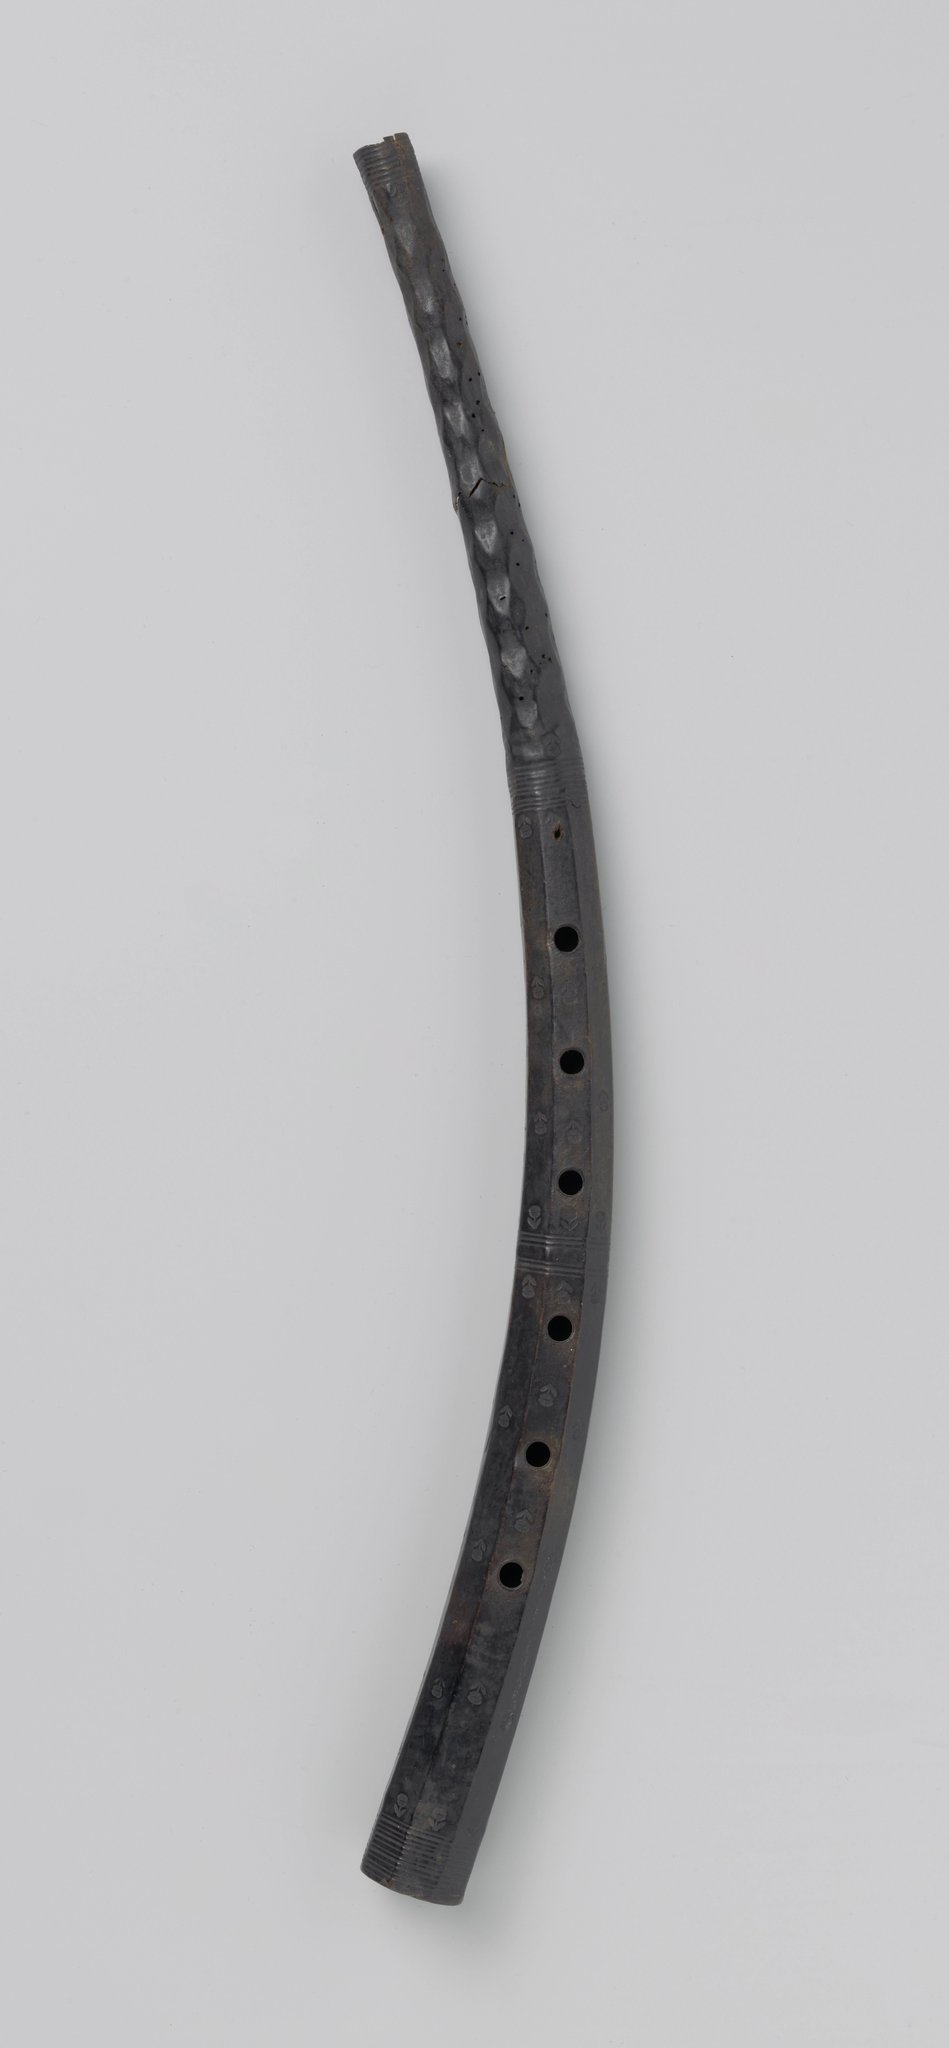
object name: wind instrument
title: Cornett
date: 1600-1650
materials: wood, leather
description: Sopraanzink (ook wel cornetto genoemd) van fruithout overtrokken met leer. Het instrument heeft zes vingergaten aan de voor- en één duimgat aan de achterzijde. Rondom gedecoreerd met in het leer geperste bloemetjes. Aan de bovenkant is een stuk afgebroken als gevolg van houtwormvraat.